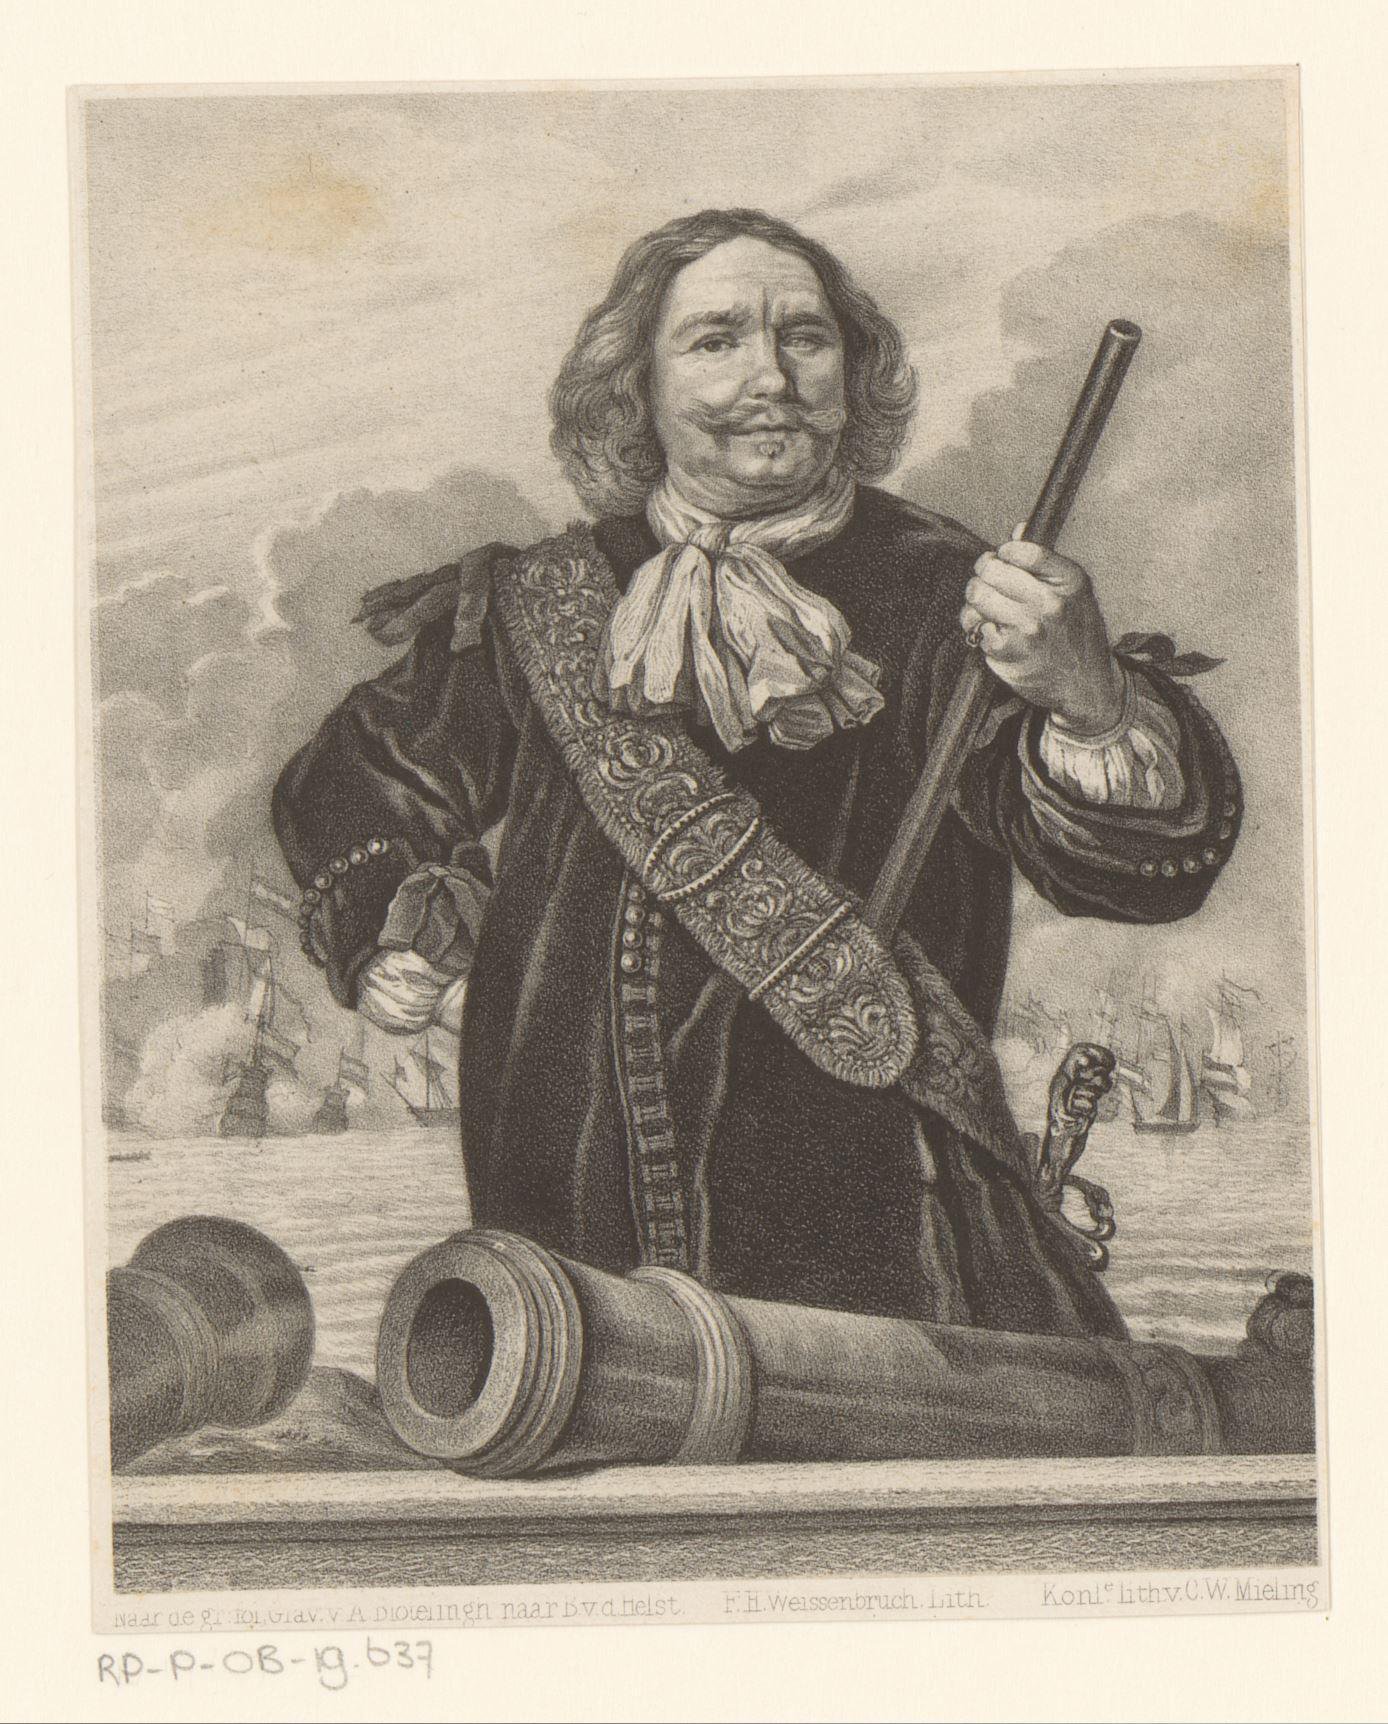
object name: print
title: Portret van Egbert Meeusz Kortenaar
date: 1858-1862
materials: paper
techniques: lithograph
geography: the hague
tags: historical persons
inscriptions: collector's mark: Lugt 2228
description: Prent uit: Jonge, J.C. de. Geschiedenis van het Nederlandsche zeewezen. Haarlem: Jonge, J.K.J. de, 1858-62.